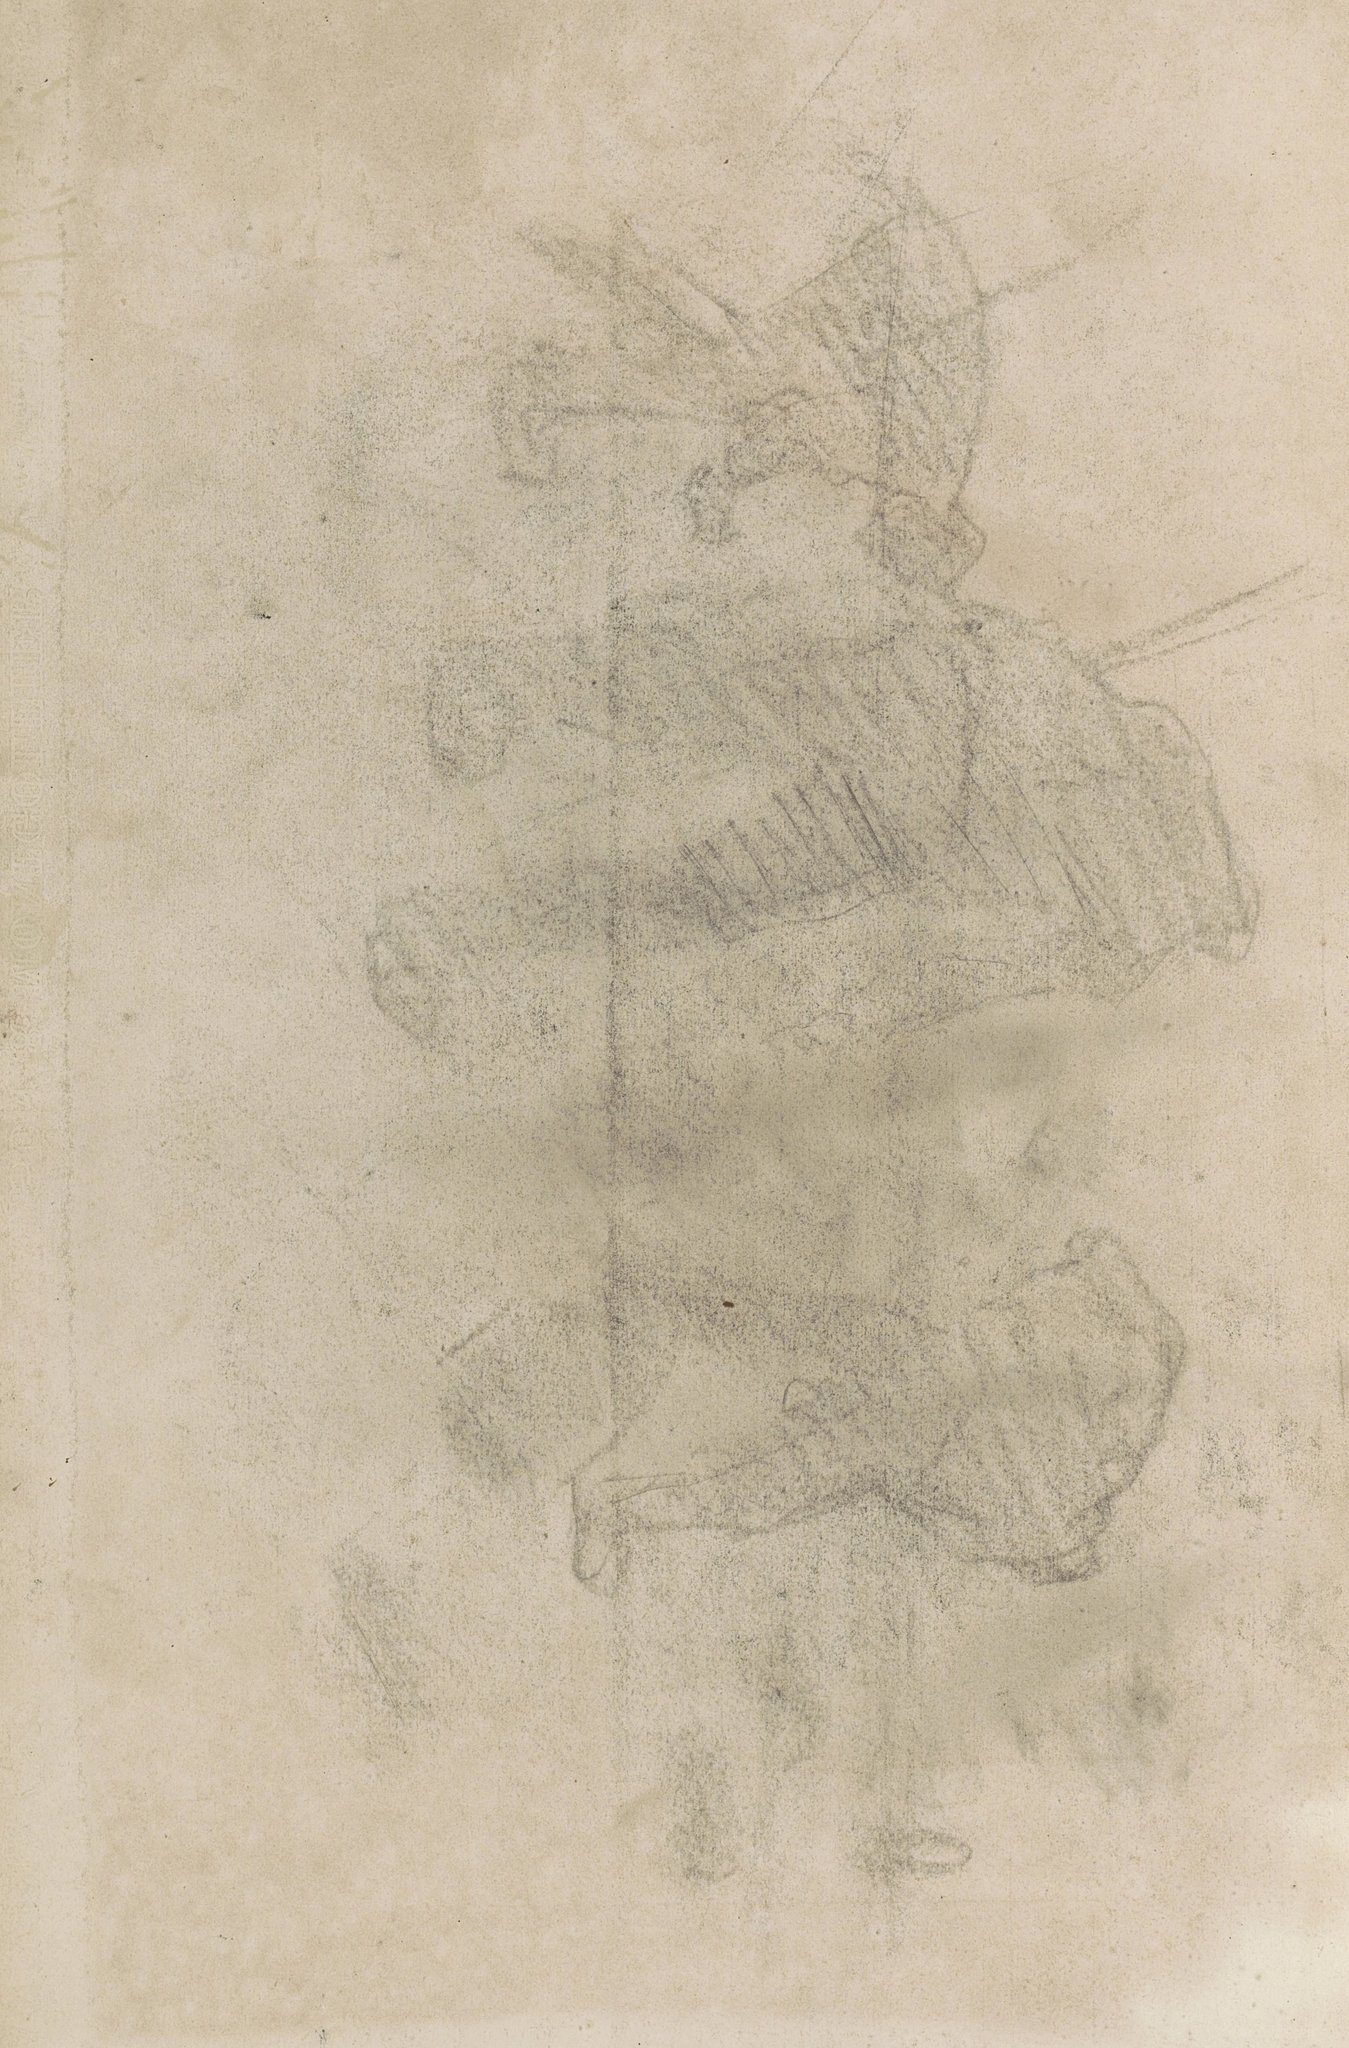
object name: sketchbook leaf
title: Drie mannen aan het werk op het land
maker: willem witsen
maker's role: draughtsman, painter, print maker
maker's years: 1860-1923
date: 1884-1887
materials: chalk, paper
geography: ewijkshoeve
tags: farmers, landscapes in the temperate zone (+ landscape with figures, staffage)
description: Pagina 78 uit een schetsboek met 38 bladen.